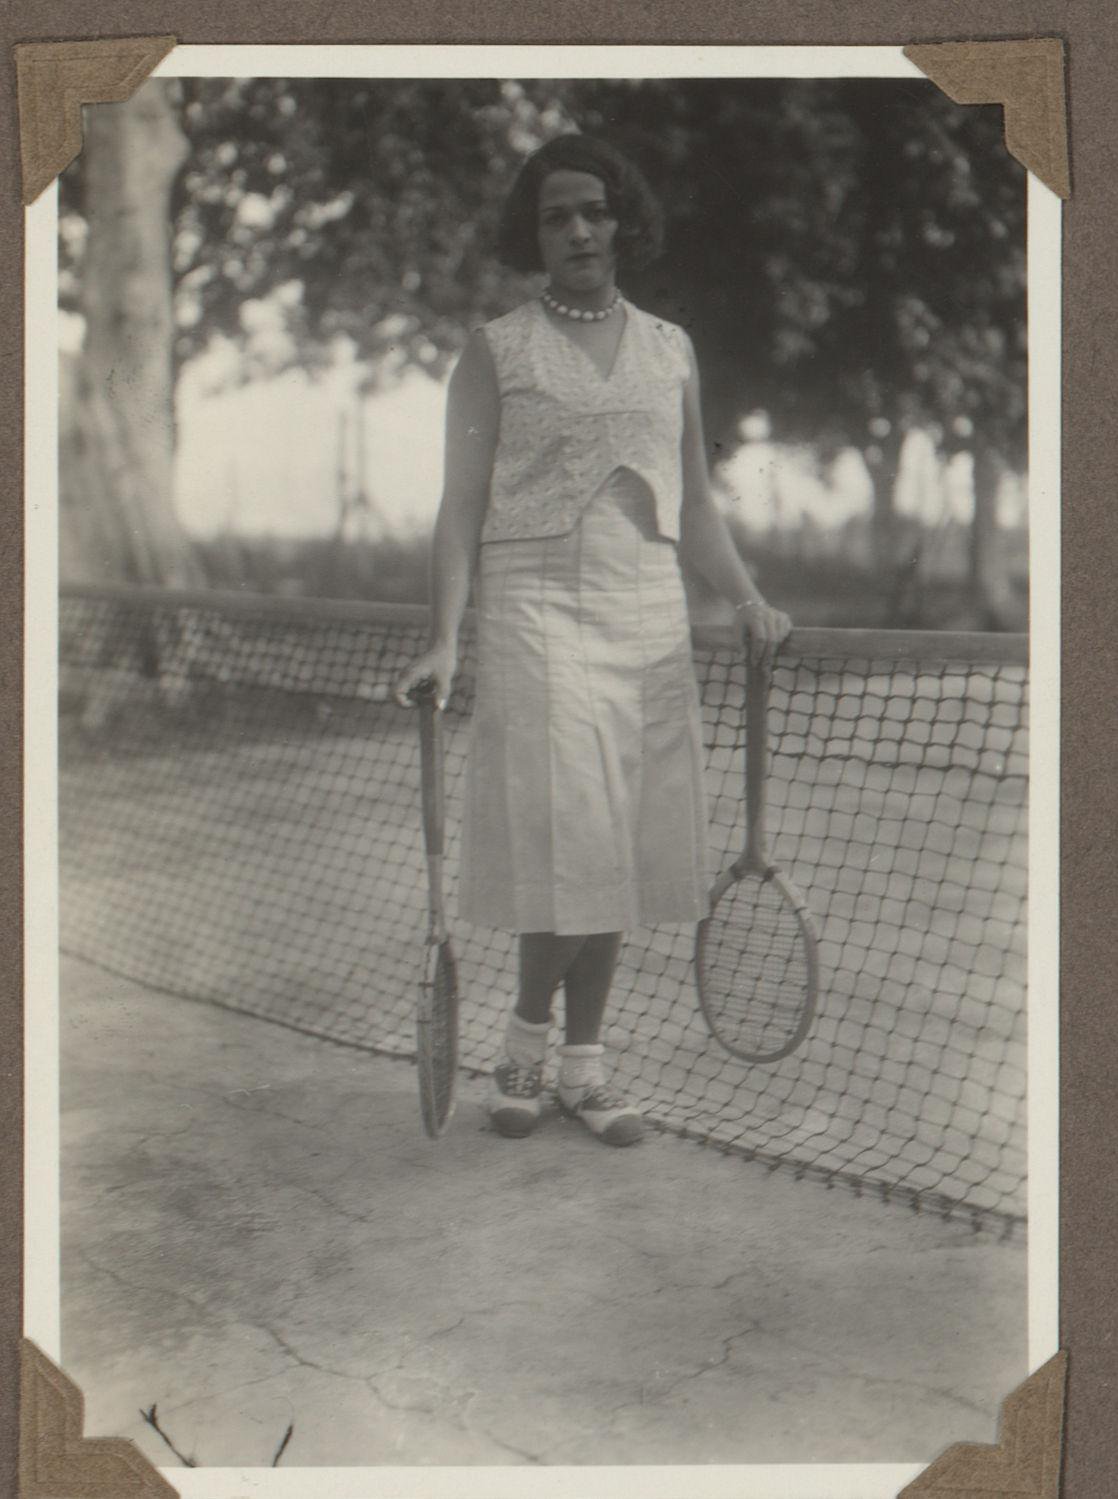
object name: photograph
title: Portret van Wilhelmina van Zijll de Jong op een tennisbaan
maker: Anonymous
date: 1930-1935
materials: paper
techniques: gelatin silver print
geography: netherlands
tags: the hague, wilhelmina van zijll de jong, tennis, lawn-tennis, adult woman, historical persons - bb - woman, netherlands